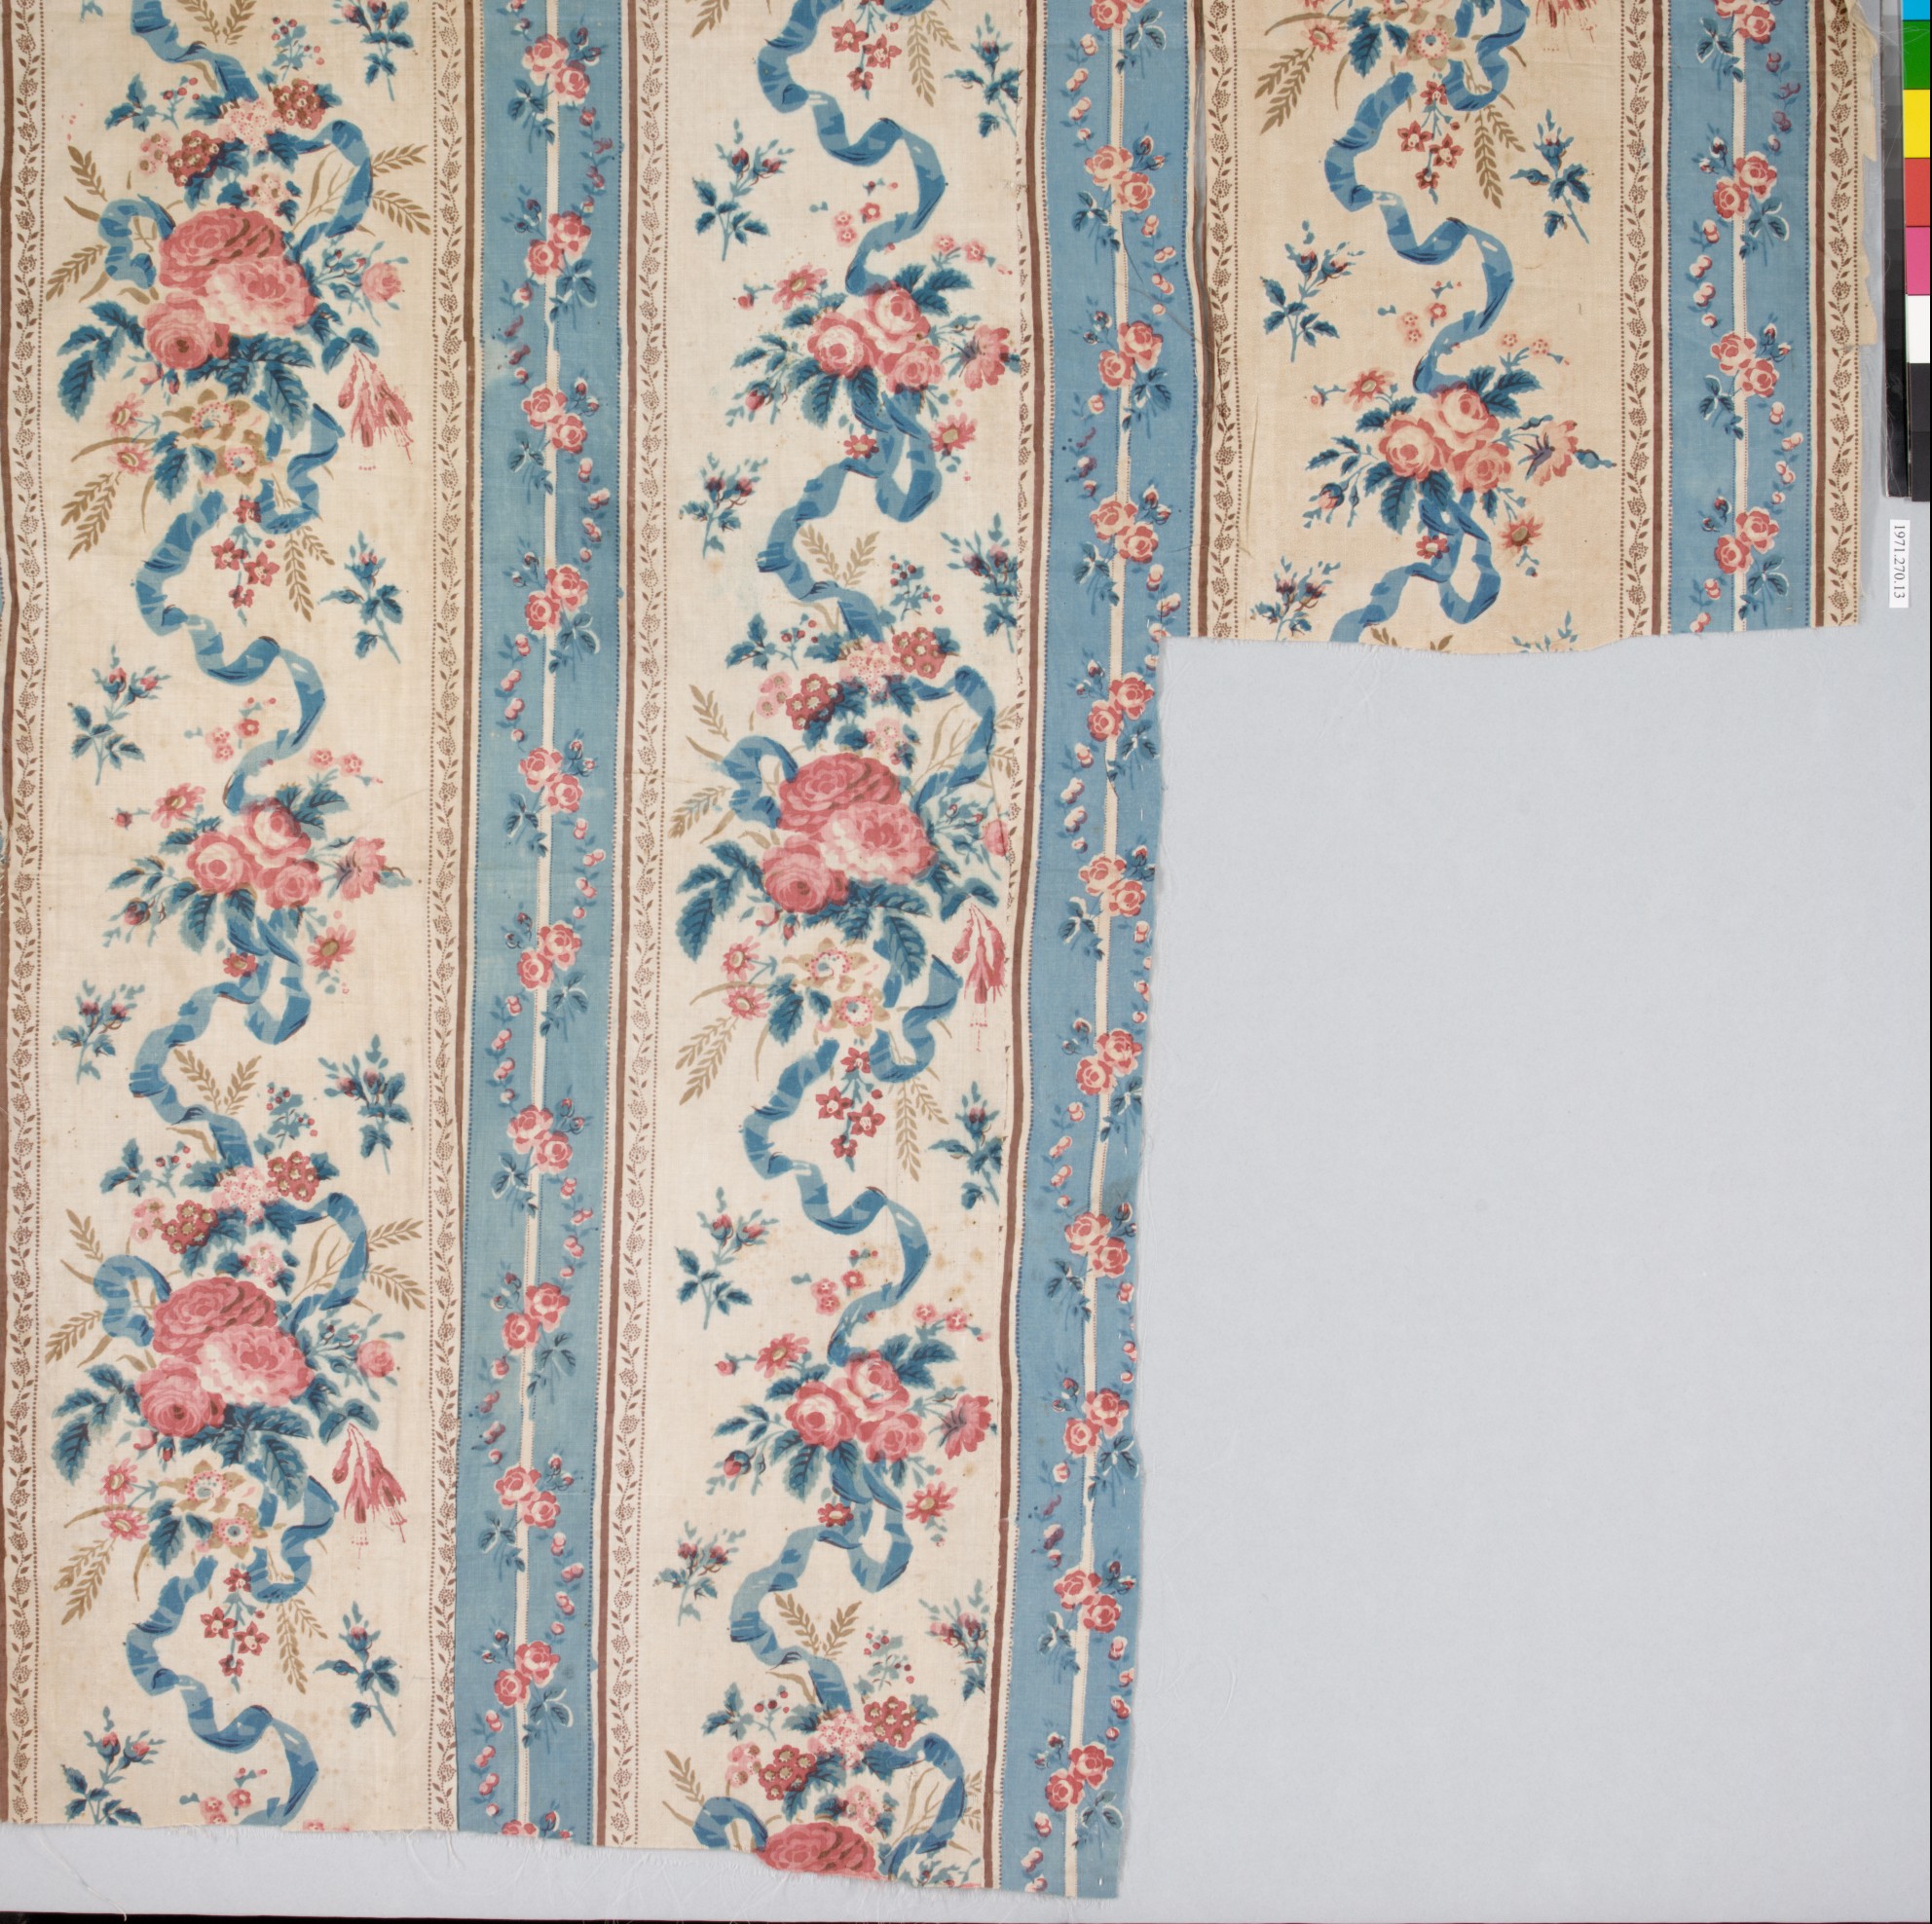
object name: piece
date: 1790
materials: cotton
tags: flowers,leaves